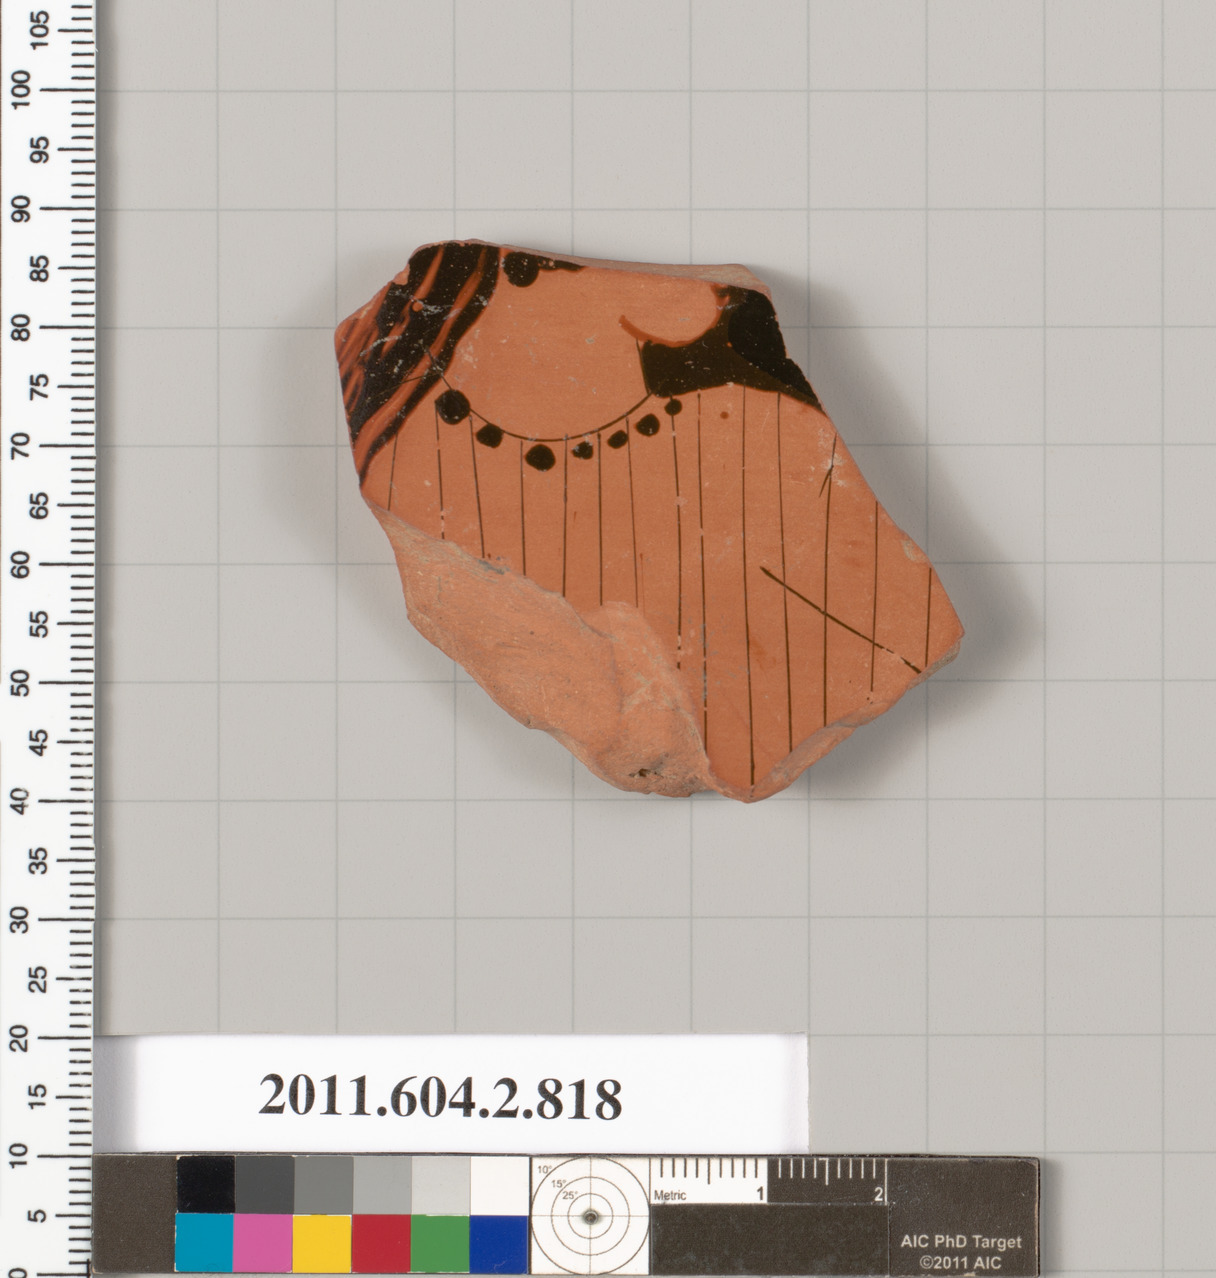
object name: bell krater fragment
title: Terracotta fragment of a bell-krater (bowl for mixing wine and water)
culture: greek, attic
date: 460-450 BCE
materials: terracotta